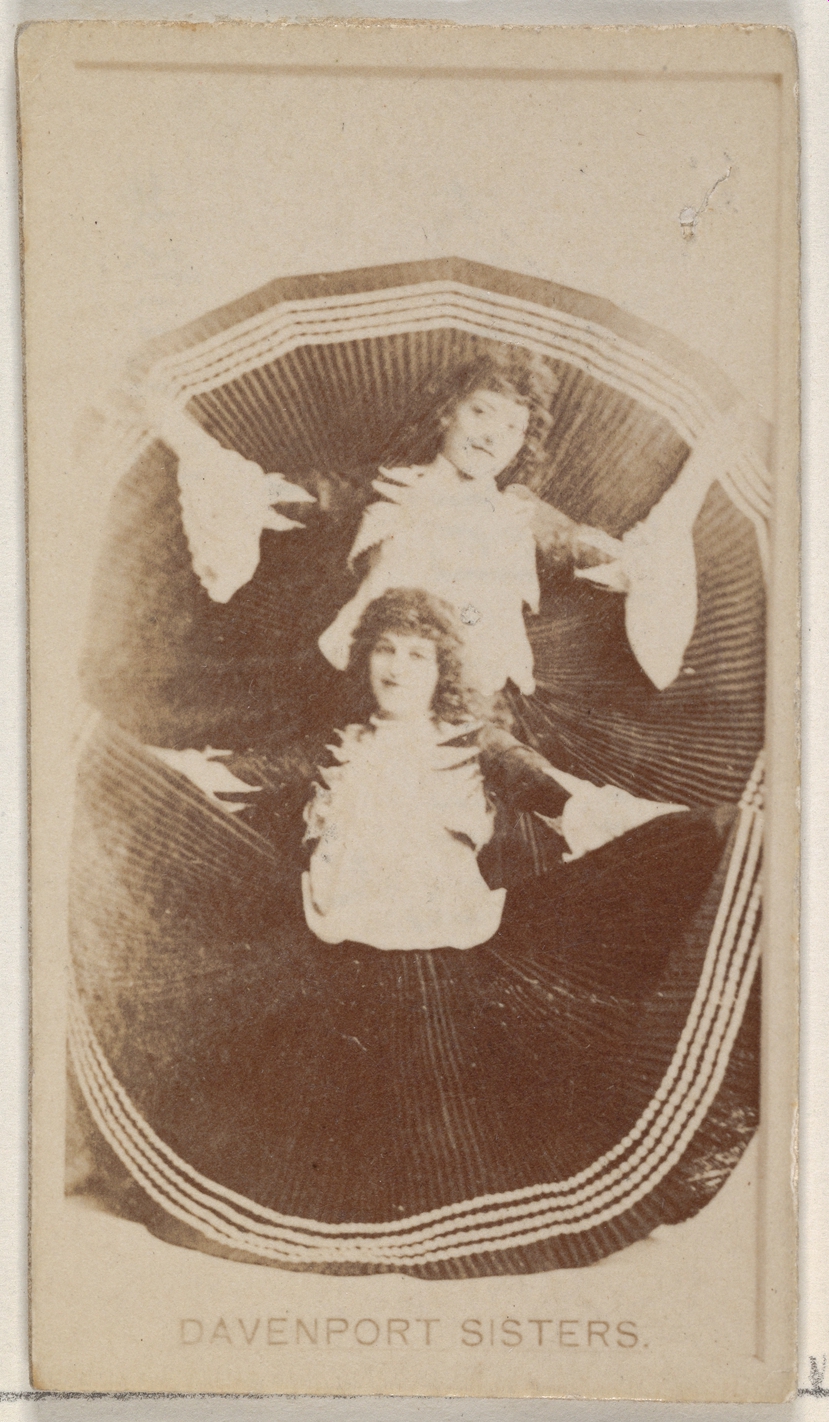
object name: photograph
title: Davenport Sisters, from the Actors and Actresses series (N45, Type 8) for Virginia Brights Cigarettes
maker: allen & ginter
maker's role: publisher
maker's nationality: american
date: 1888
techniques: albumen silver print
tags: portraits,women,actresses